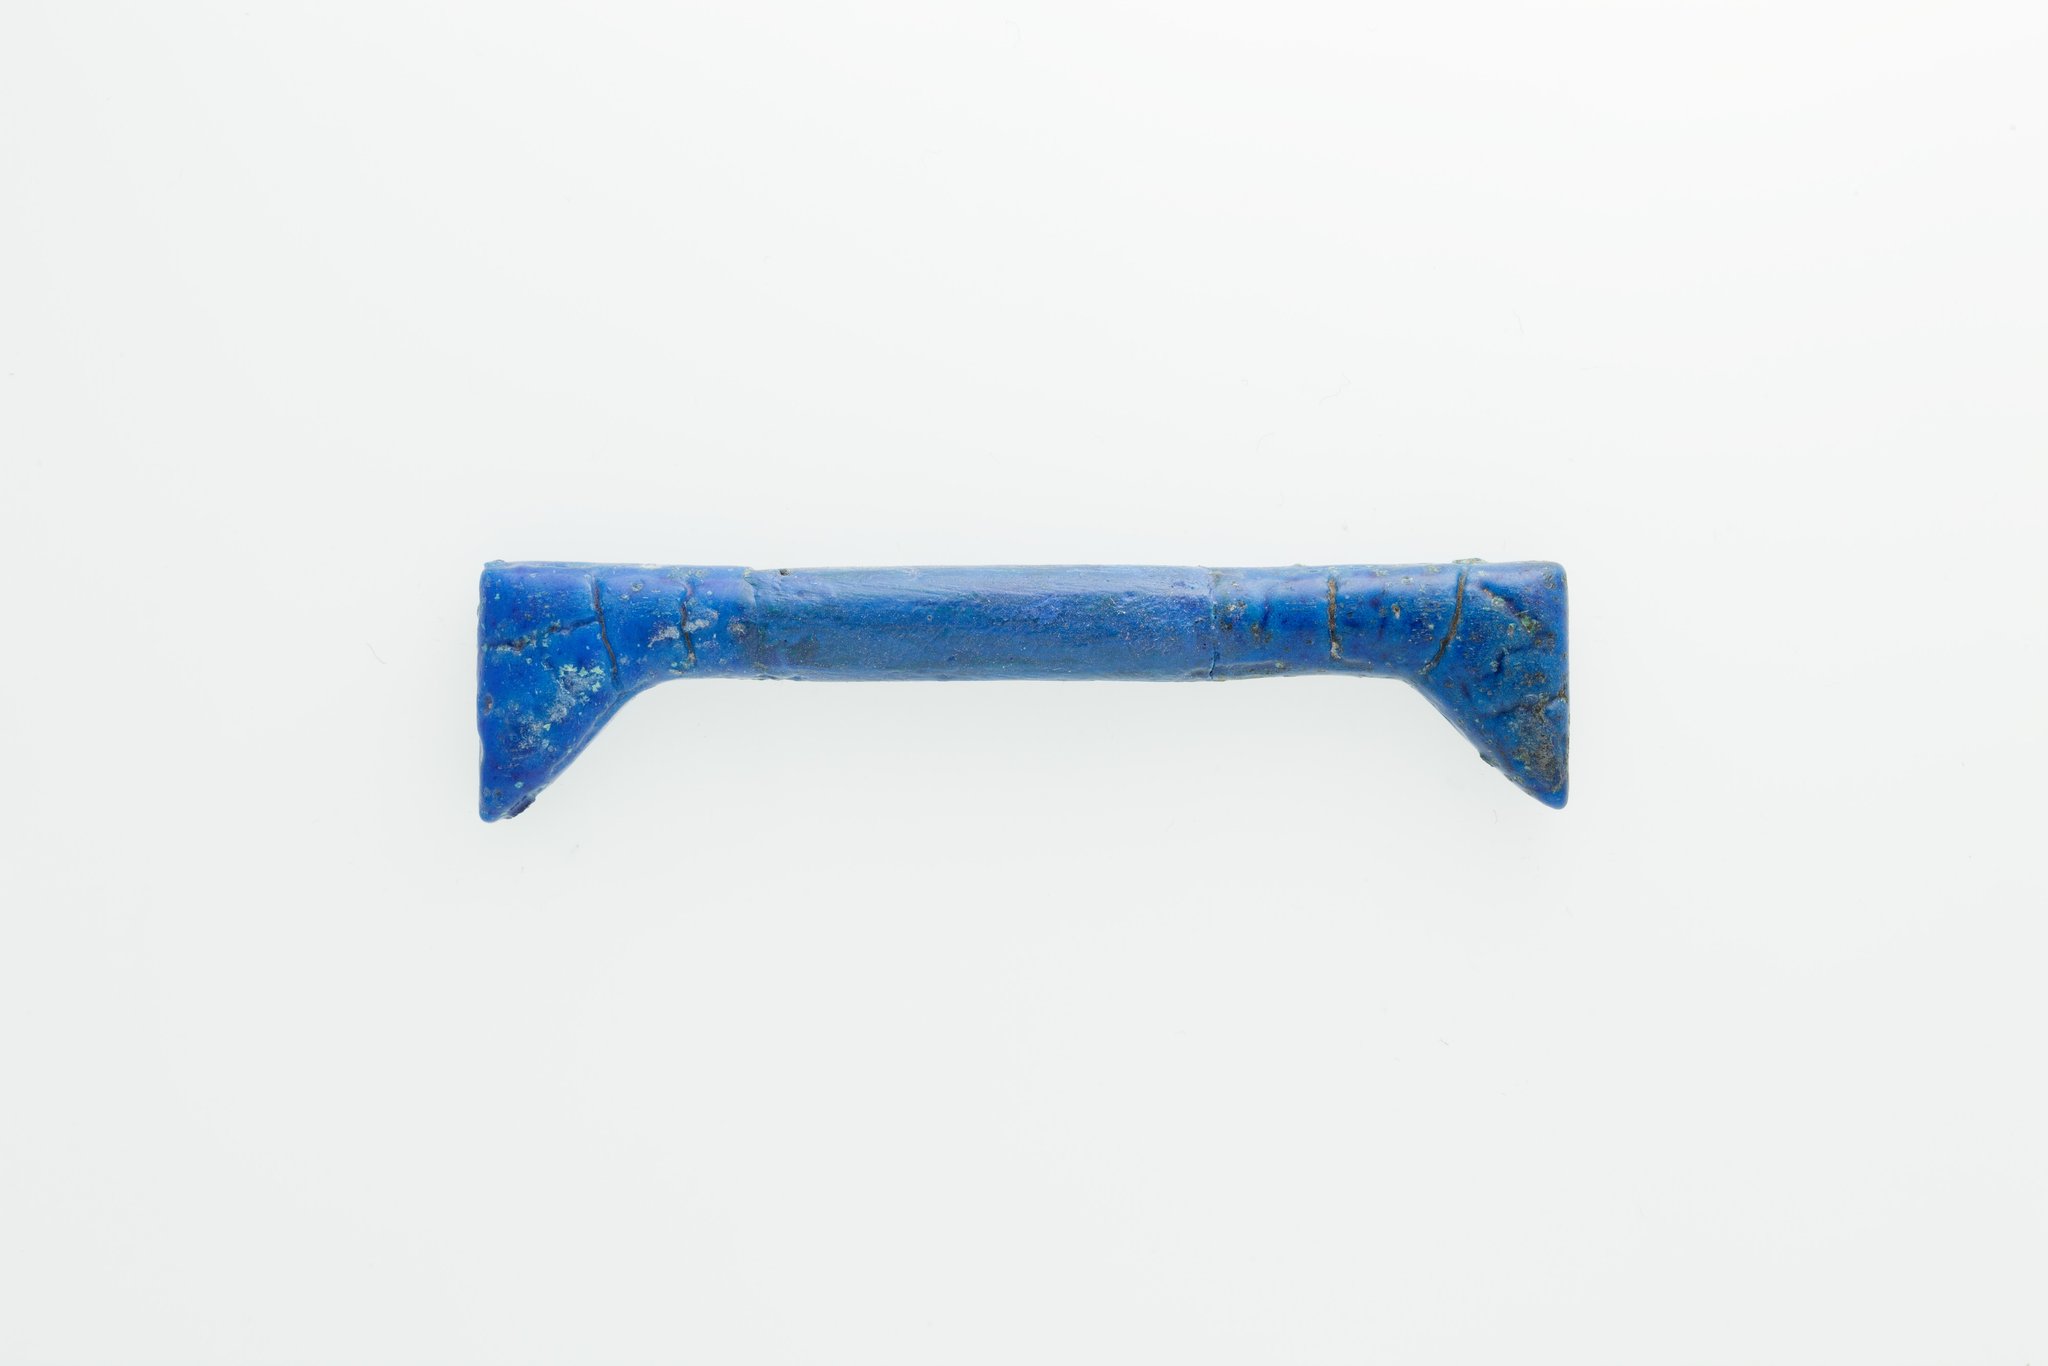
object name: inlay, hieroglyph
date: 664-610 BCE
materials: faience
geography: egypt